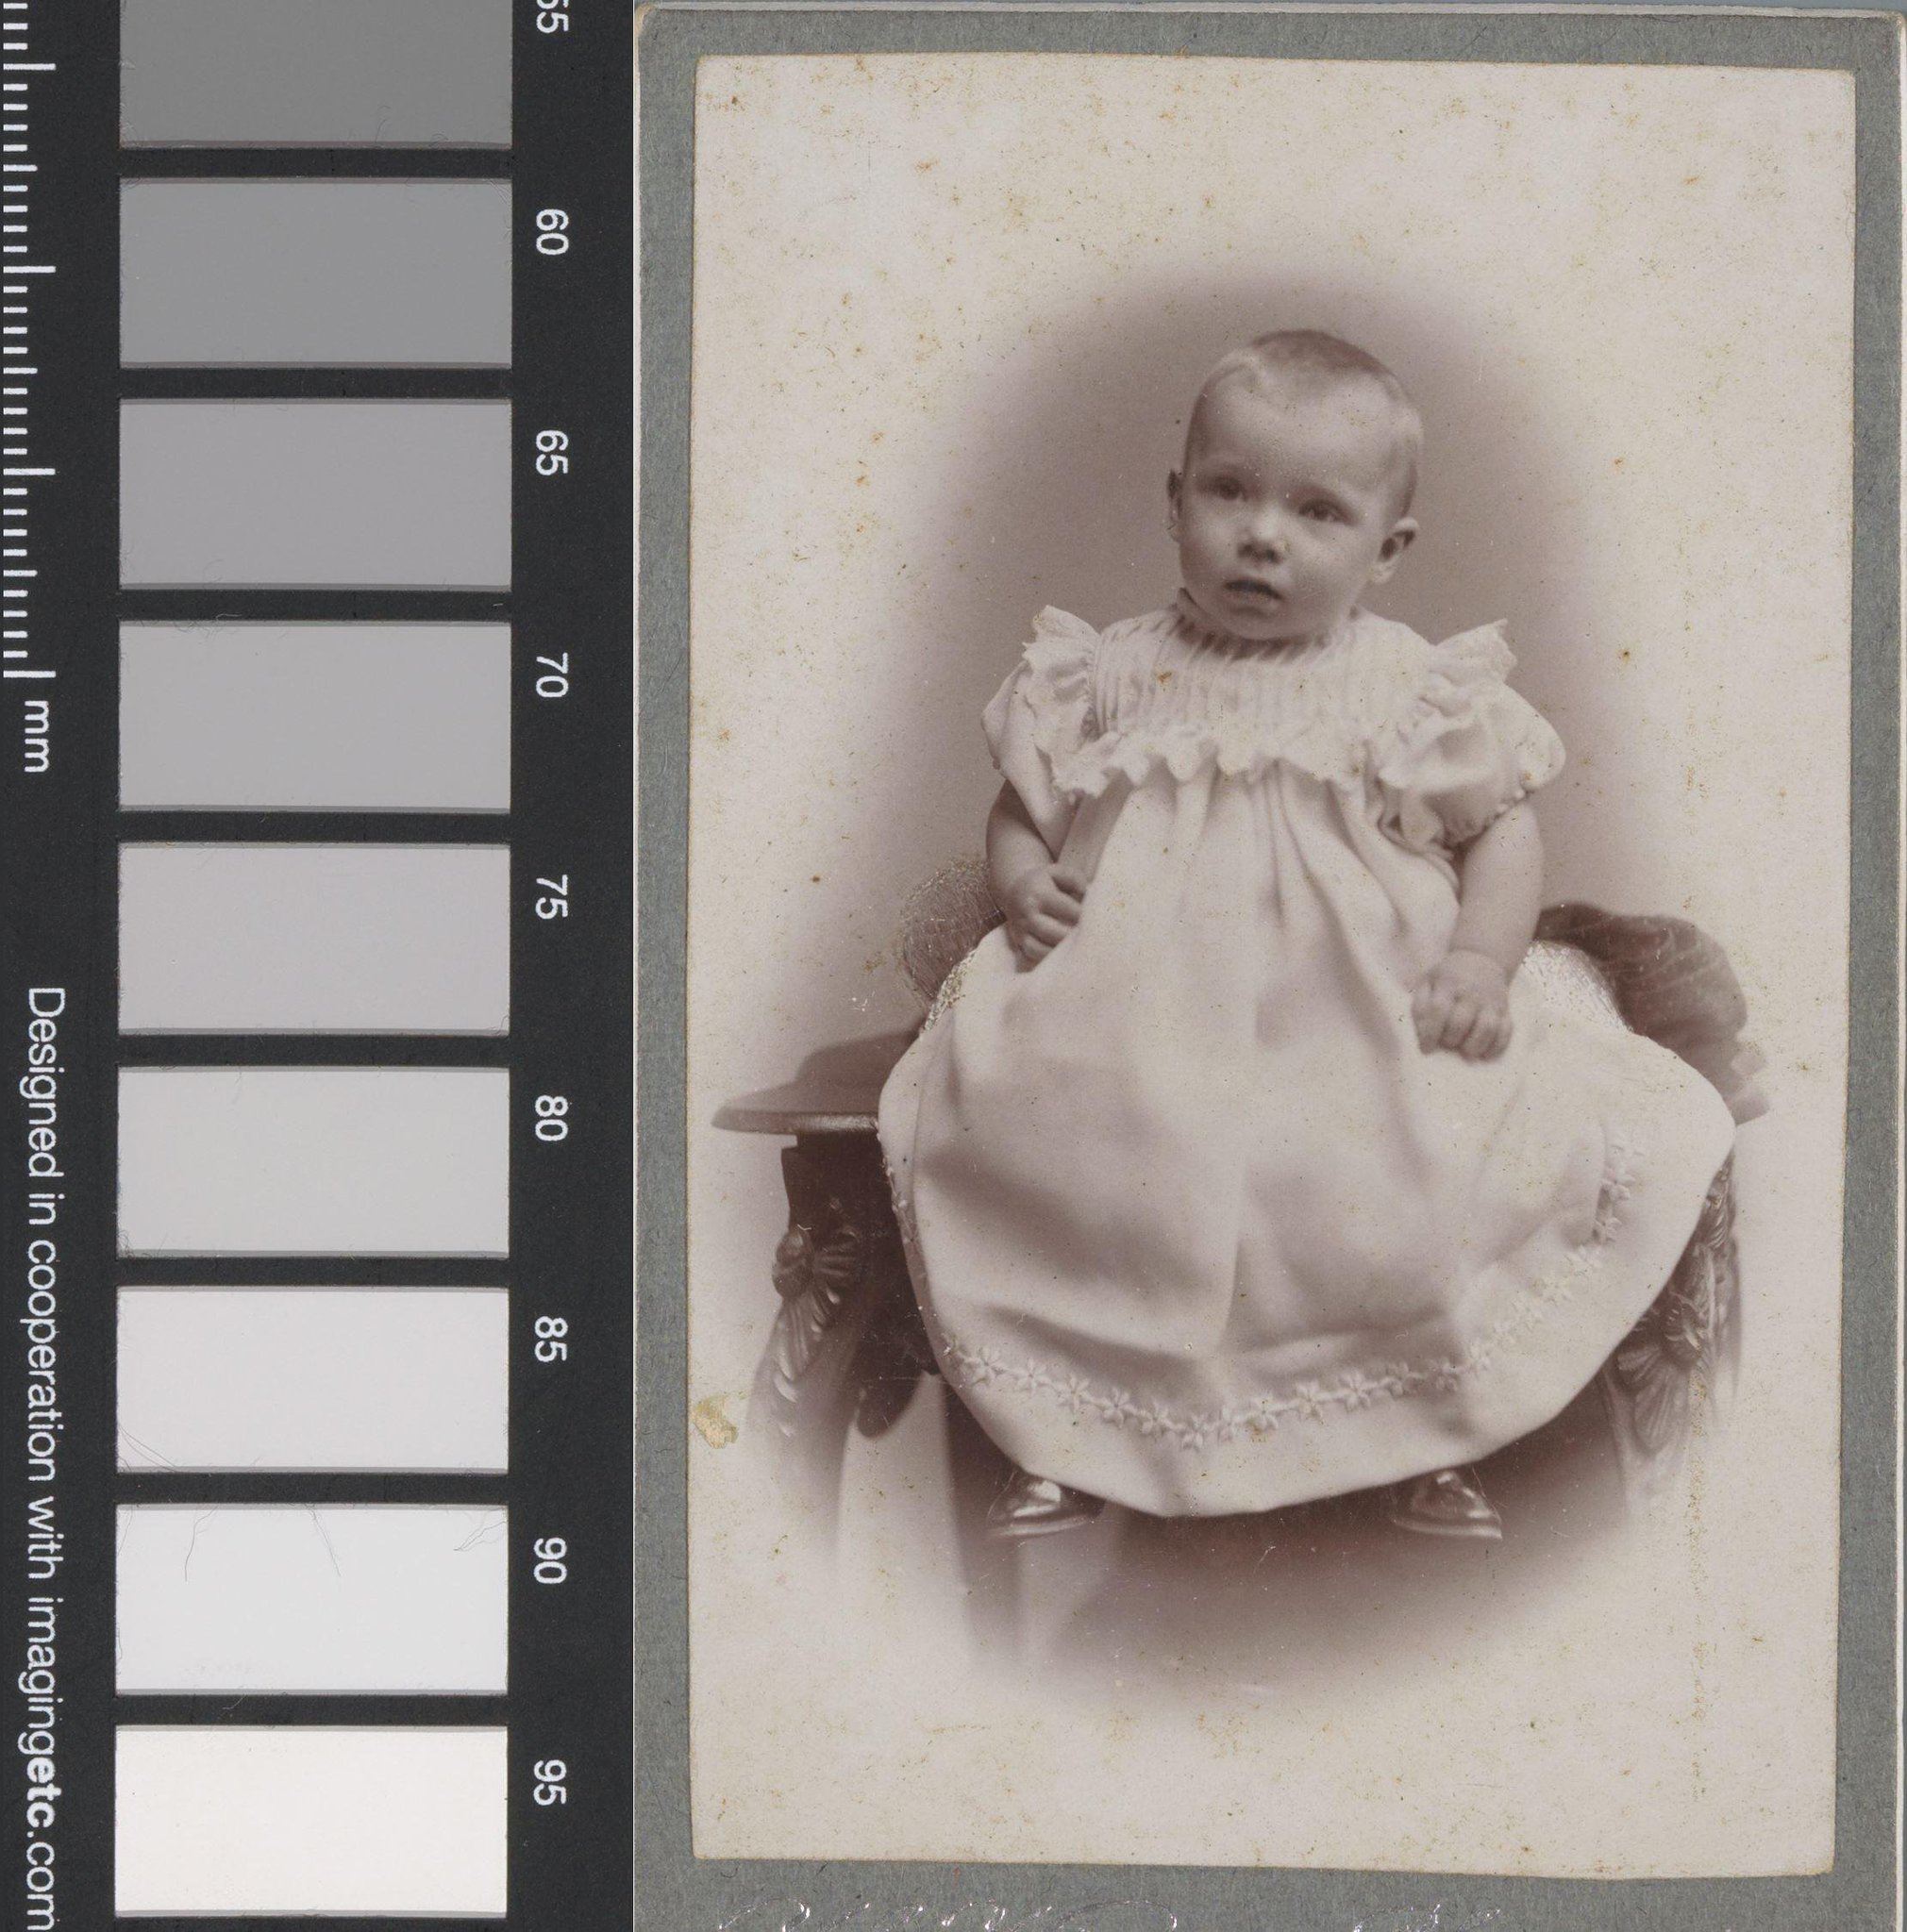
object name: carte de visite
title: Portret van een onbekende baby, aangeduid als de zoon van Gijs Kraaij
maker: jacob kuyper (1851-1919)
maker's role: fotograaf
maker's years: 1851-1919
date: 1880-1919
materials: cardboard, photographic support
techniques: collodion silver print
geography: zaandam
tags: historical persons, infant, baby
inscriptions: inscription: ‘zoon van Gijs/ Kraaij’